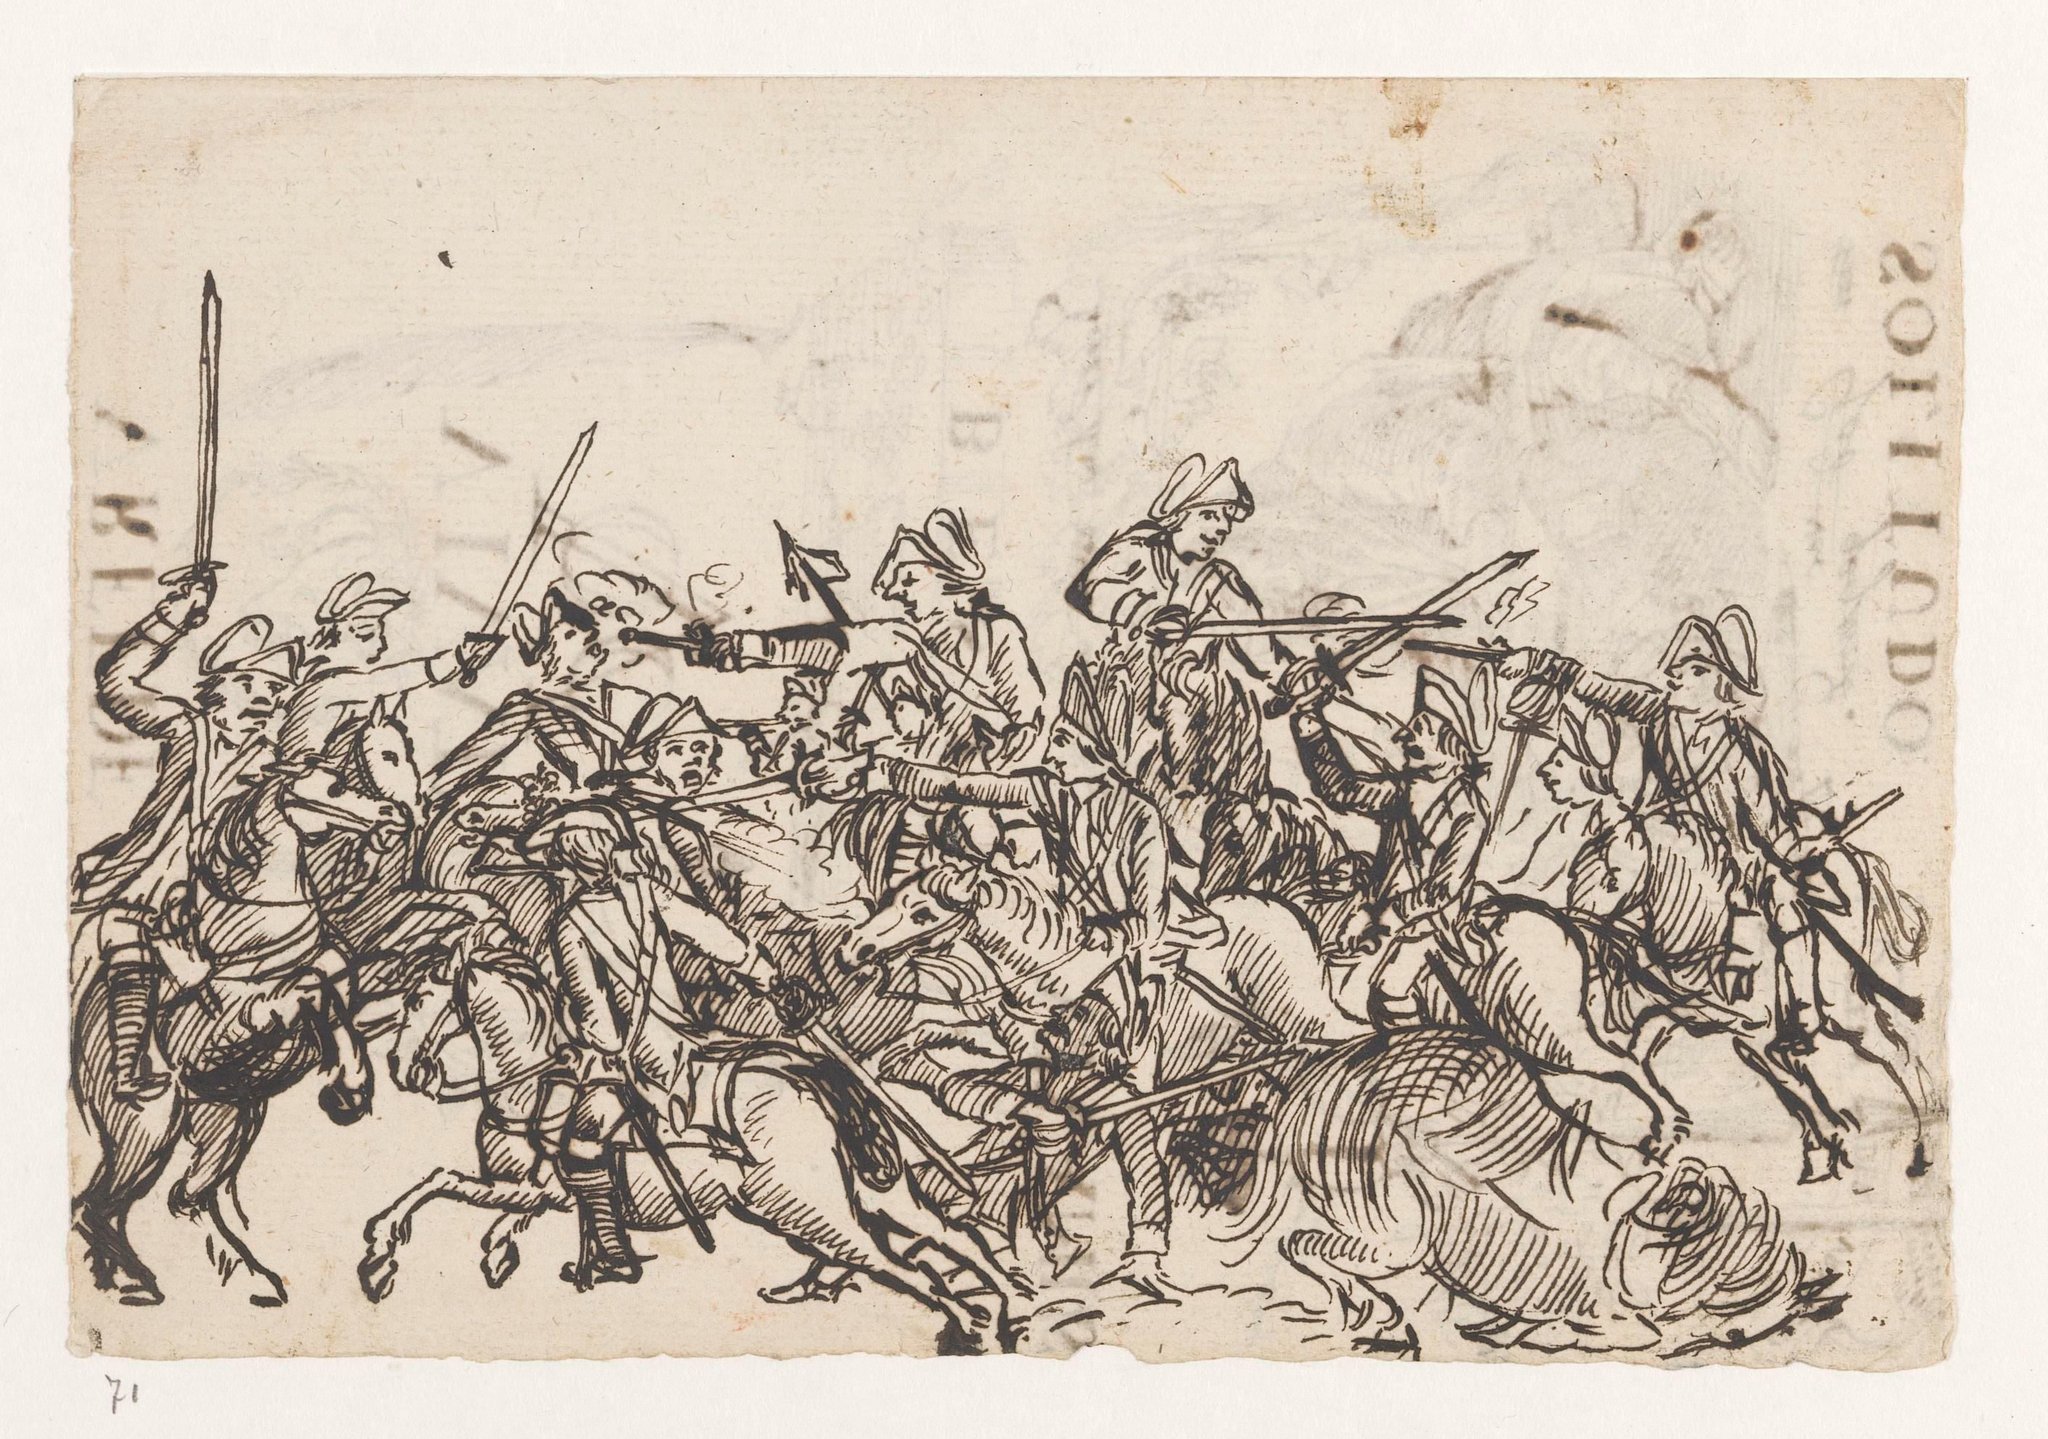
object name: drawing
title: Ruiterslag / Allegorie op de Engelse oorlog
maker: jan brandes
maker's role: draughtsman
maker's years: 1743-1808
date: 1784-1785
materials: ink, paper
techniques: pen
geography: jakarta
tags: battle (+ cavalry, horsemen), fourth anglo-dutch war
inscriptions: inscription: ‘VIVAMUS generaal aaltings waapen STEUN DER VRYHEID’, inscription: ‘Dit loft, van God ik zwijg sijt ... van God ver gegund. SOLITUDO’, inscription: ‘VREEDE VIVAT VOC harum ope. BEST’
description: Woeling van vechtende ruiters op rennende, vallende en steigerende paarden. Verso emblemen die verwijzen naar de politieke toestand in de jaren 1784-85. Bovenaan een zwaard met afgebroken punt, ganzeveer, leeuw binnen krans en monogram VOC. Links onder een verbeelding van Brandes' persoonlijk misnoegen: een man in habijt schrijft in een boek met rechts naast hem een jongen. Rechts onder een vrijheidslans waarop hoed en mercuriusstaf naast een boom. Achter een schip.